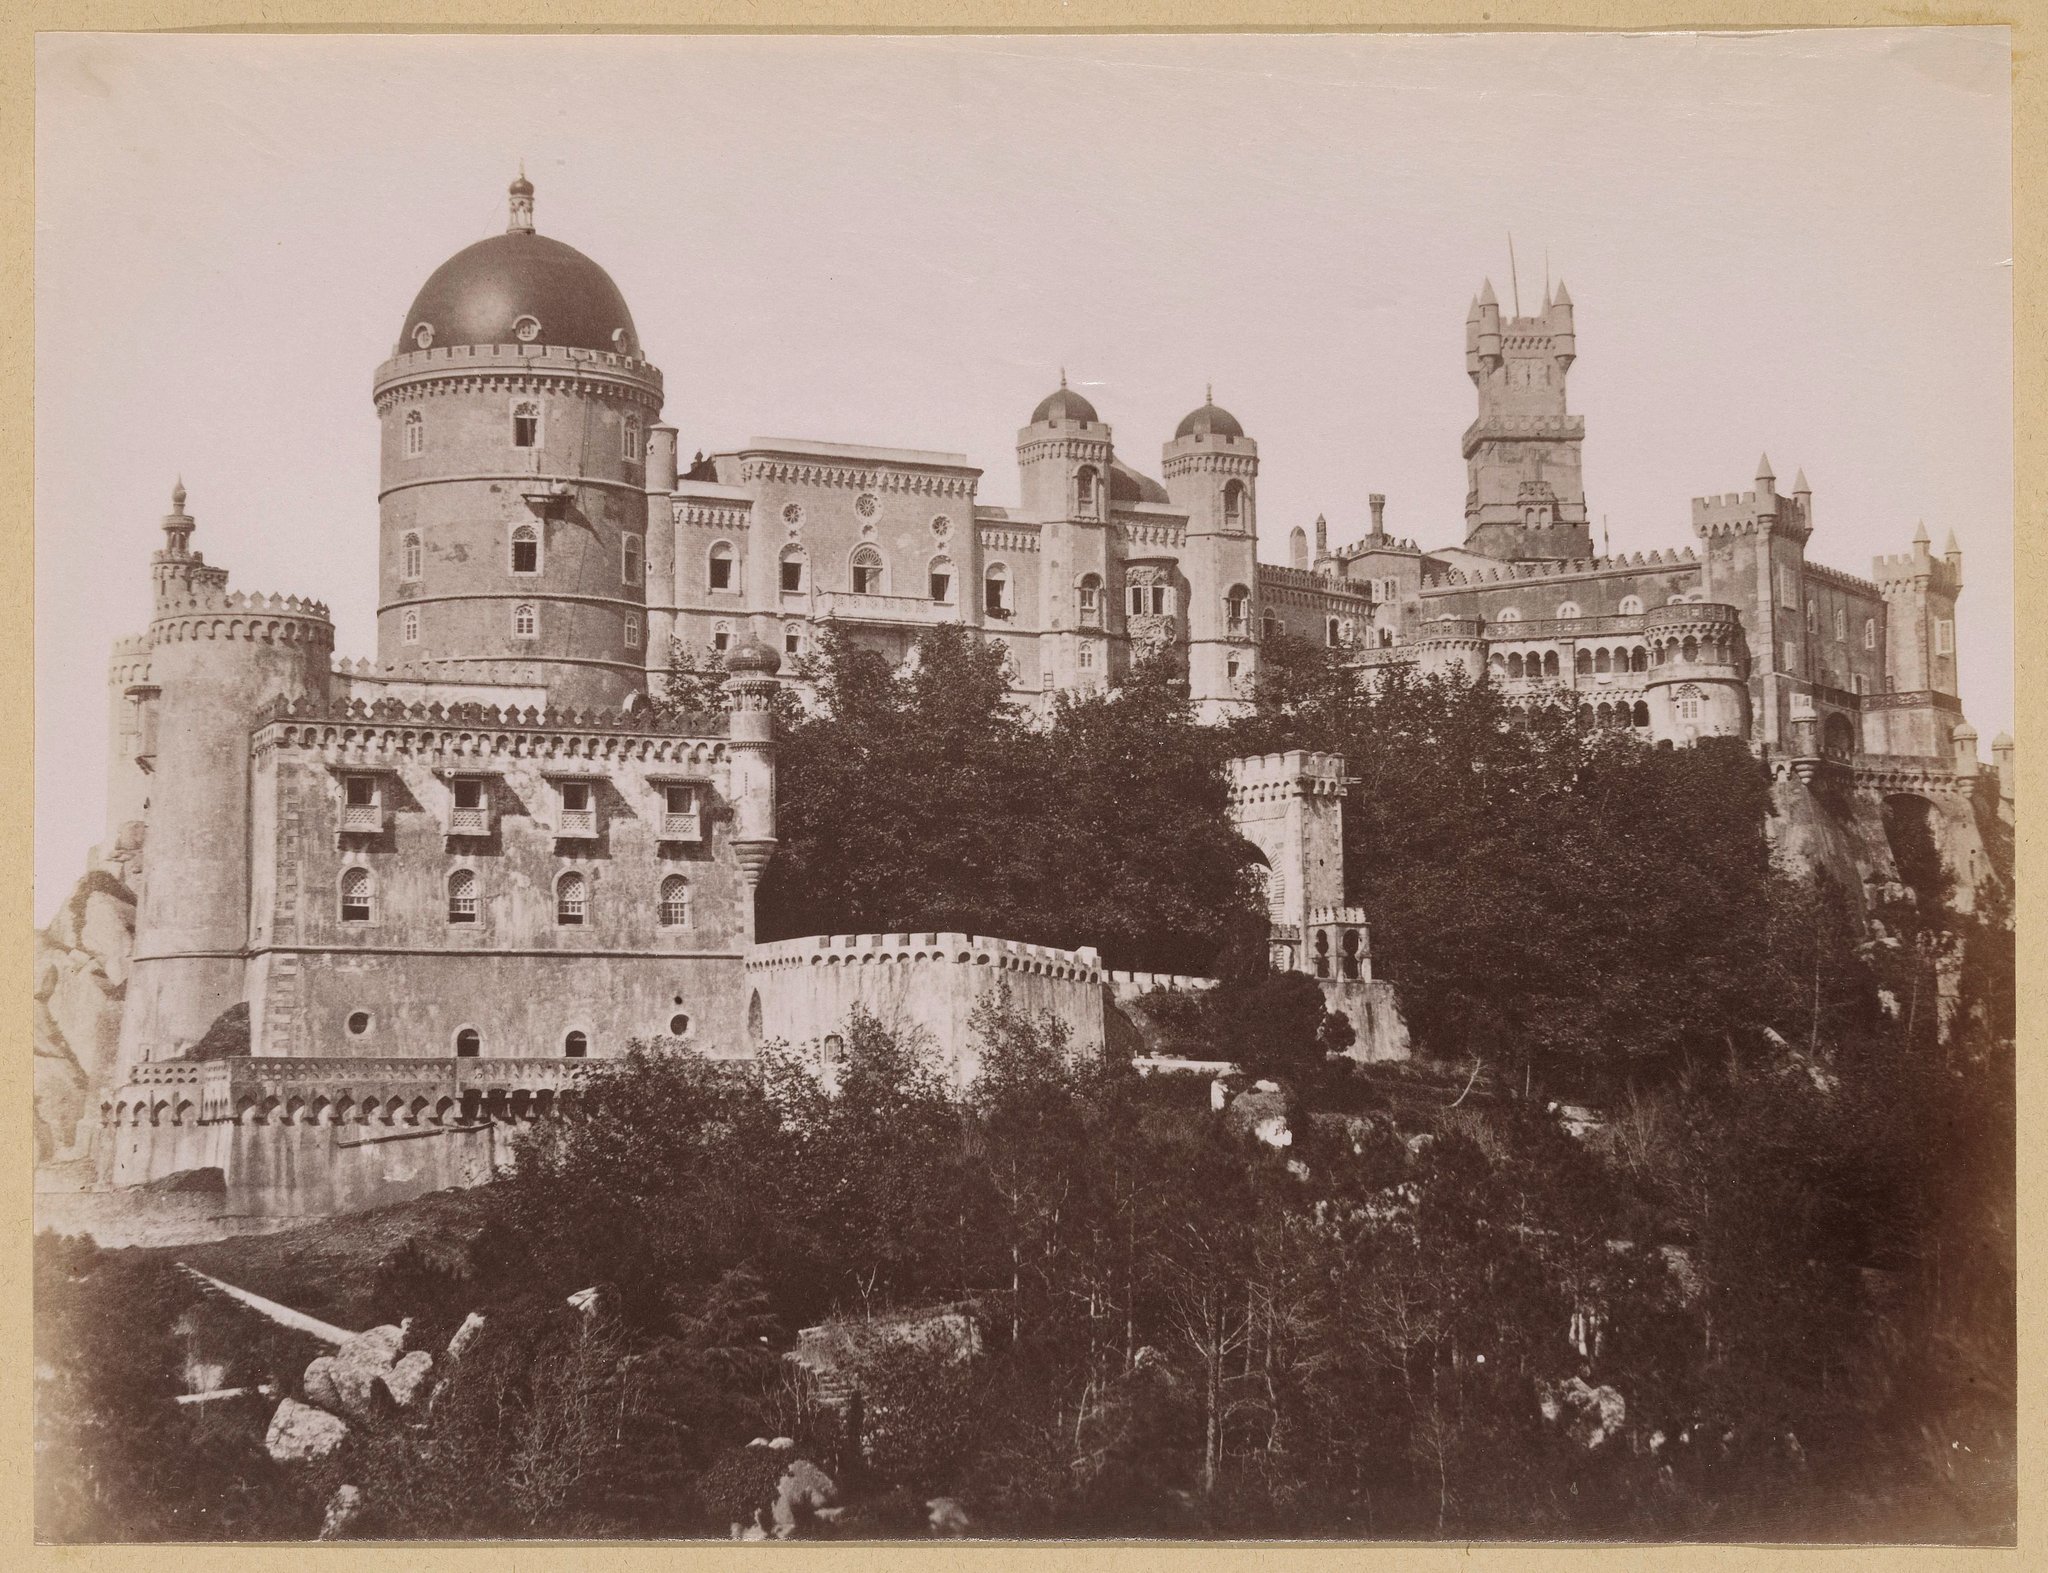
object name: photograph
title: Gezicht op Palácio da Pena nabij Sintra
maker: Anonymous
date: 1851-1890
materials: paper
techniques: albumen print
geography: sintra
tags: castle